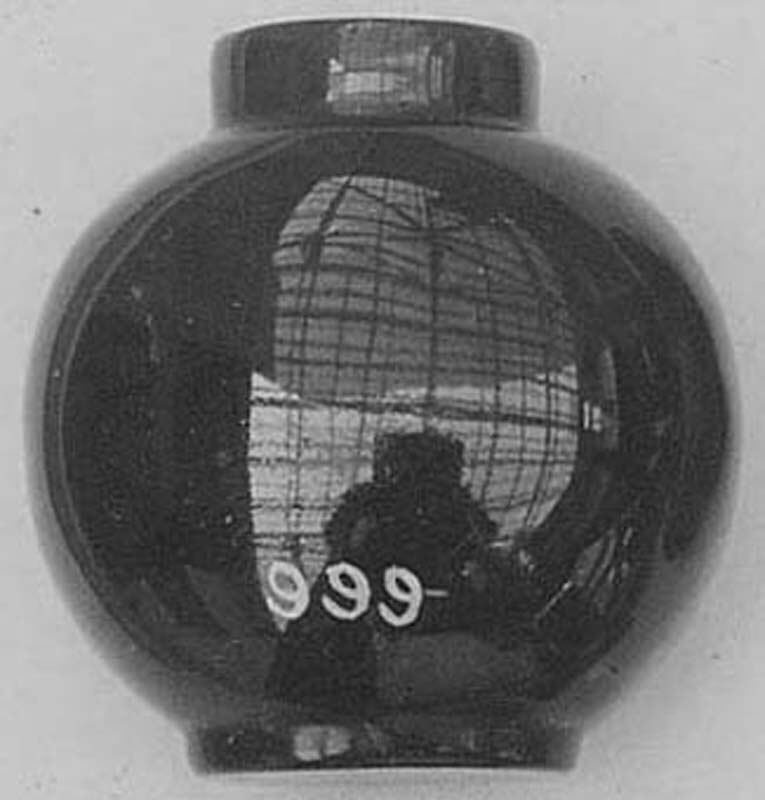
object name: snuff bottle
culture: chinese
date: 1701-1900